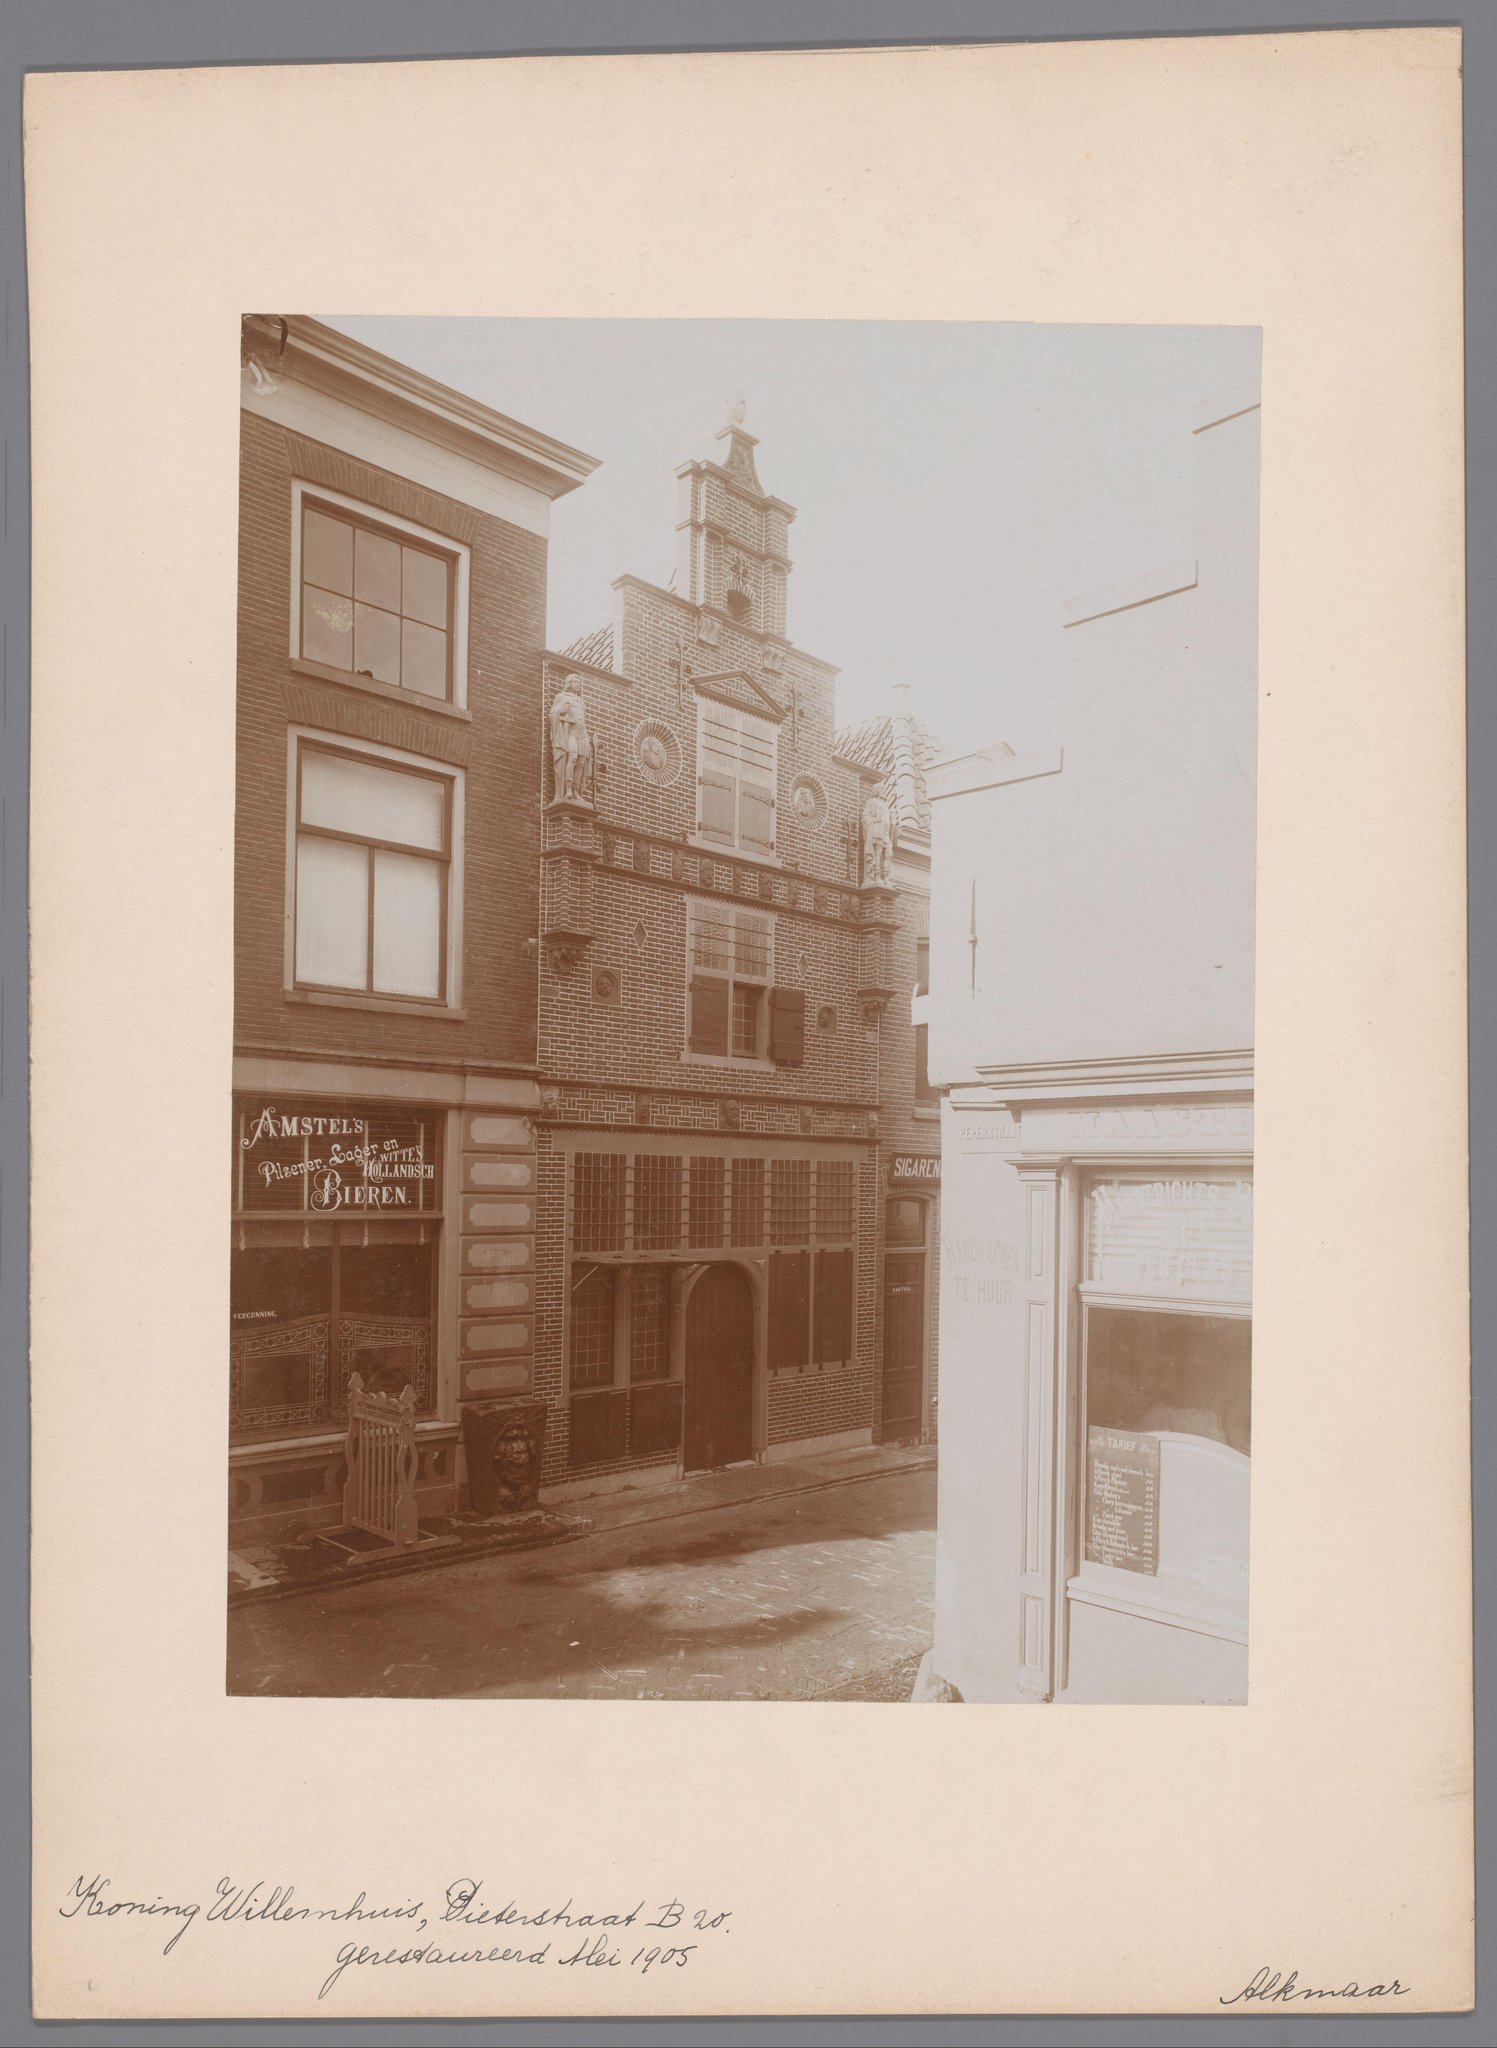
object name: photograph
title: Gezicht op het Koning-Willemshuis op Pieterstraat 16 te Alkmaar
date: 1905-1915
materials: cardboard, photographic support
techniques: collodion silver print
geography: pieterstraat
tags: urban housing, façade (of house or building)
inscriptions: annotation: ‘Alkmaar (N.H.)/ Koning Willemhuis/ gerestaureerd/ Mei 1905’, annotation: ‘Koning Willemhuis, Pieterstraat B20/ gerestaureerd Mei 1905/ Alkmaar’